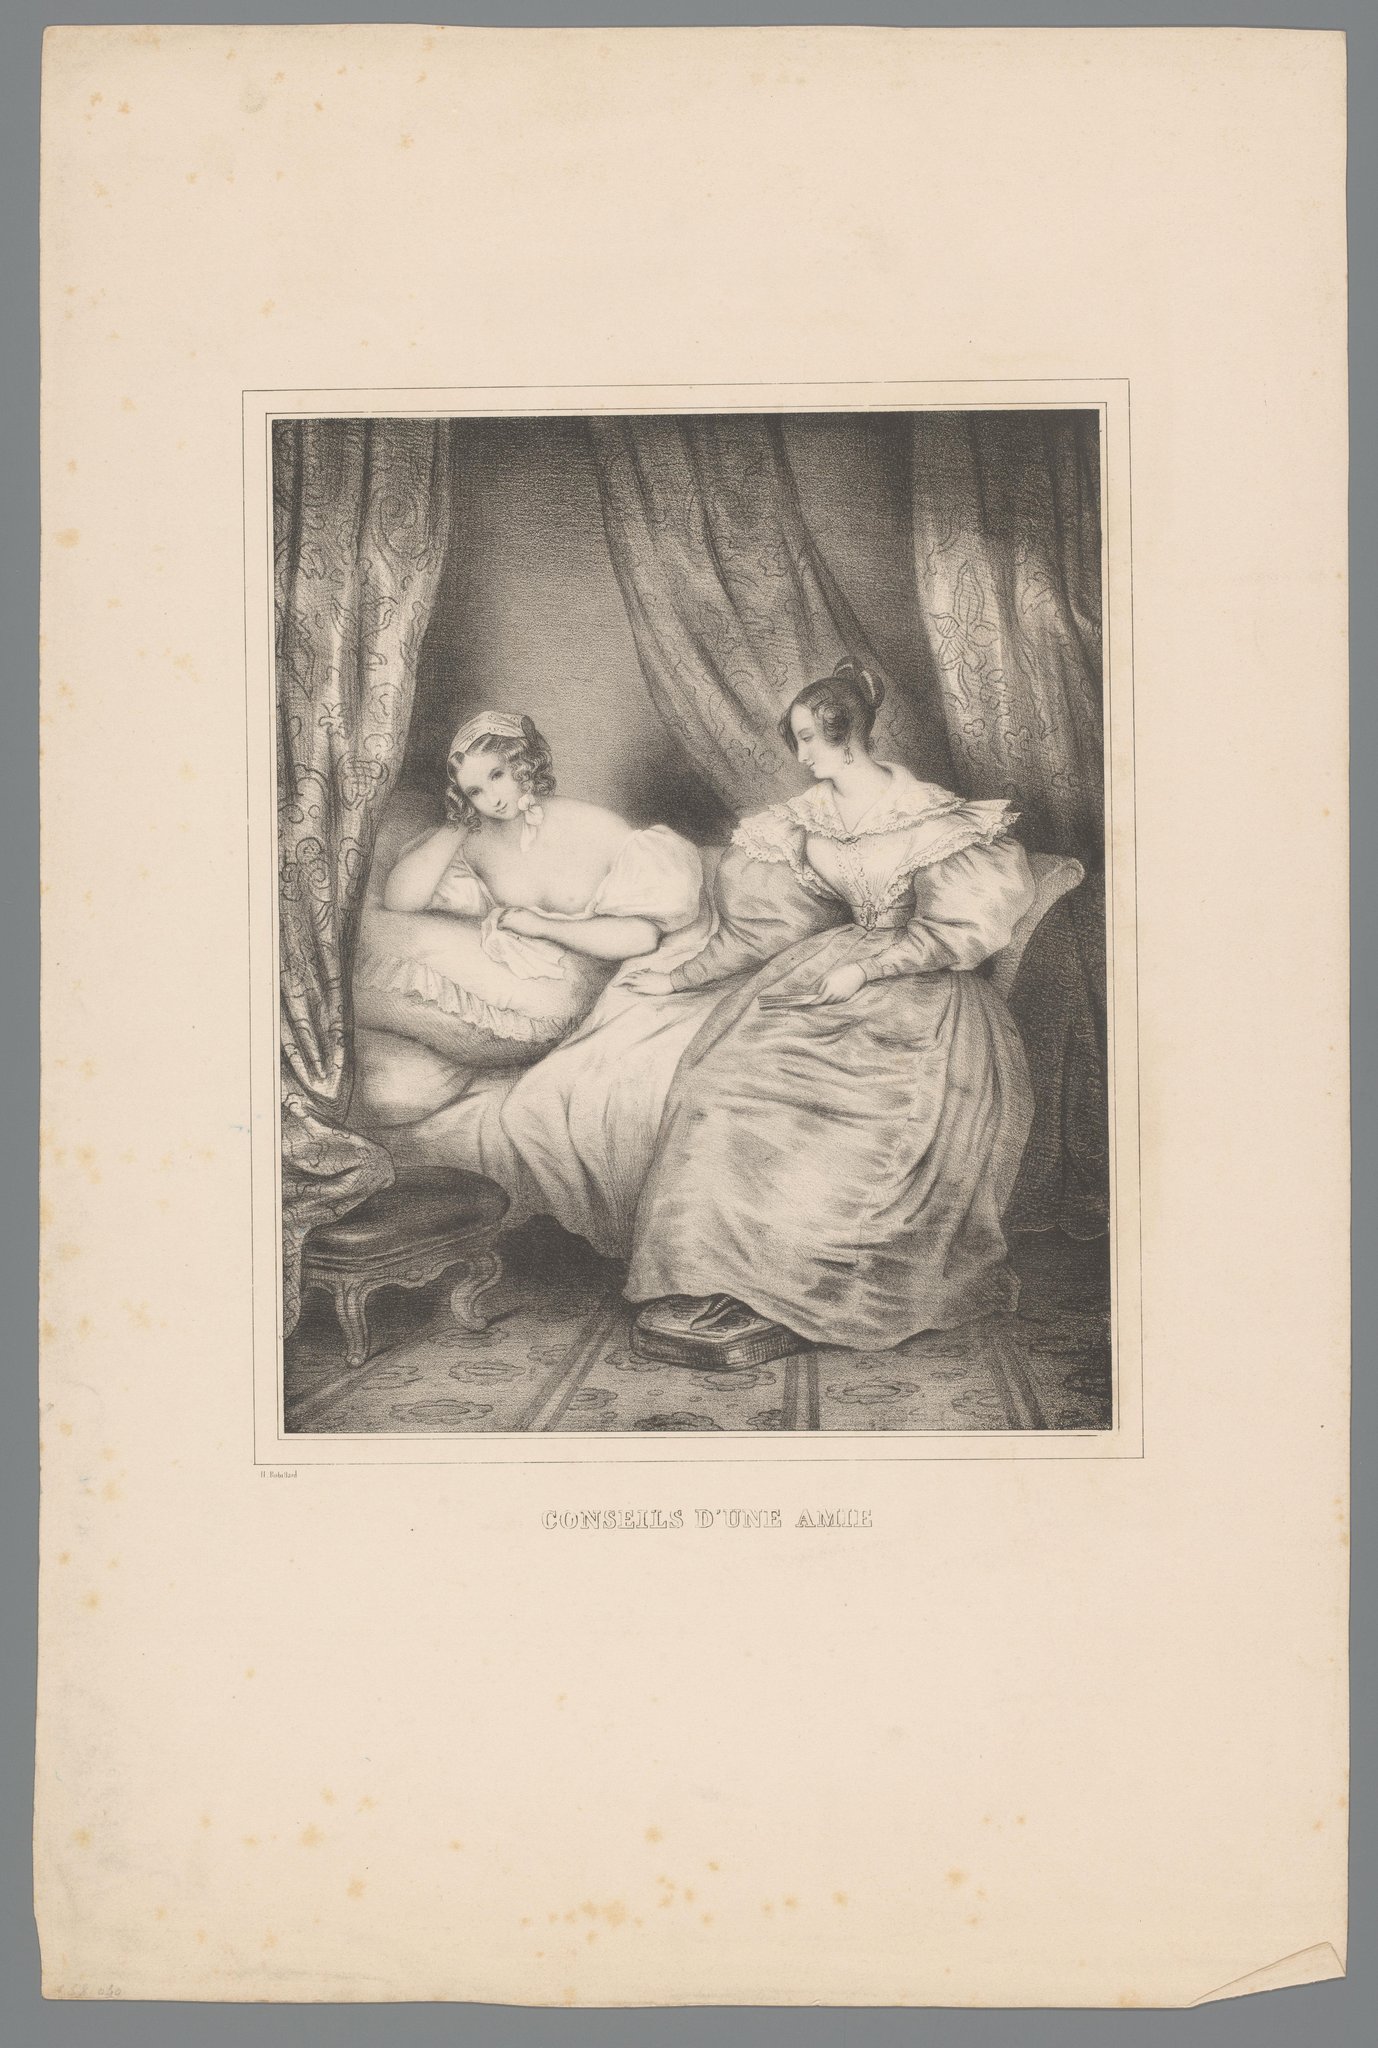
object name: print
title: Conseils d'une amie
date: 1832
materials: paper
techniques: lithograph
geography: paris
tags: friends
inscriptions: collector's mark: Lugt 2228